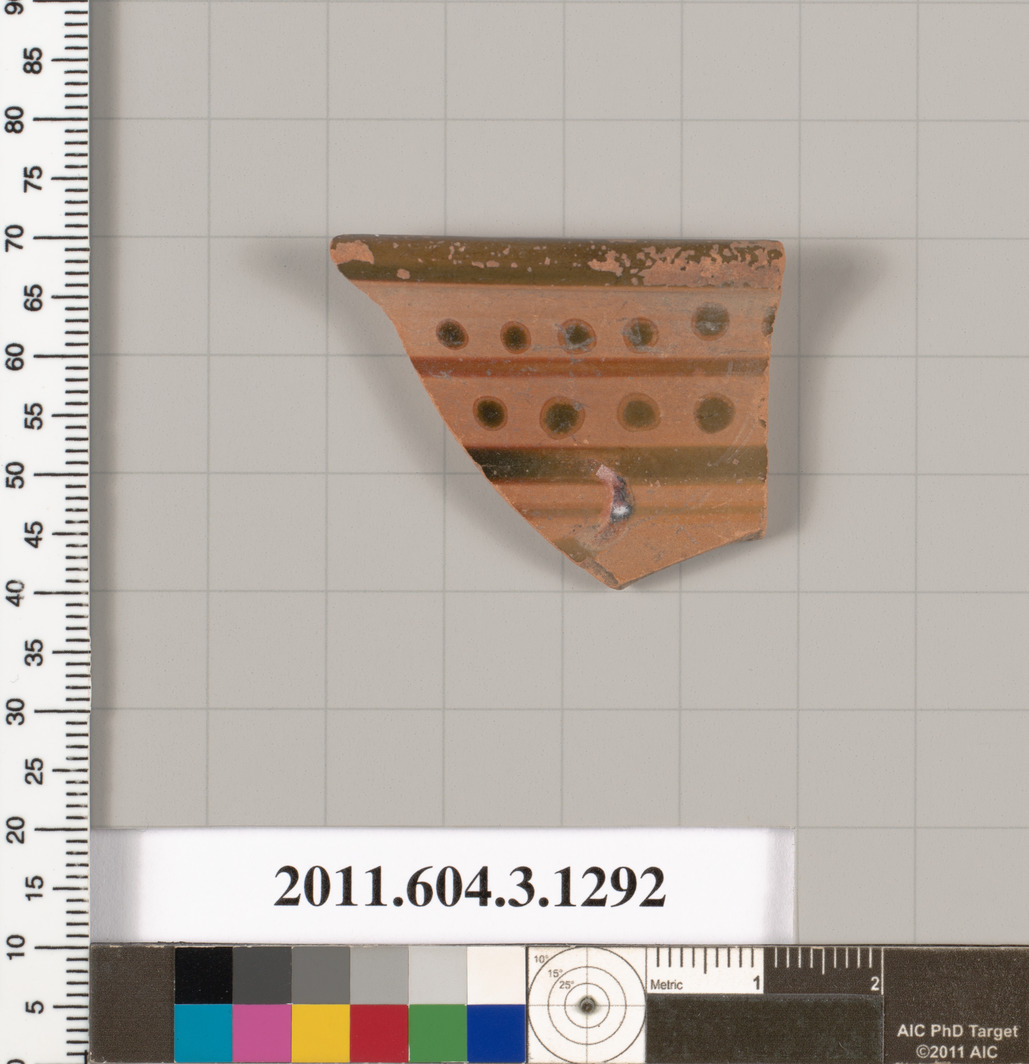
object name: skyphos fragment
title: Terracotta rim fragment of a skyphos (deep drinking cup)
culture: greek, attic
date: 500 BCE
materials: terracotta